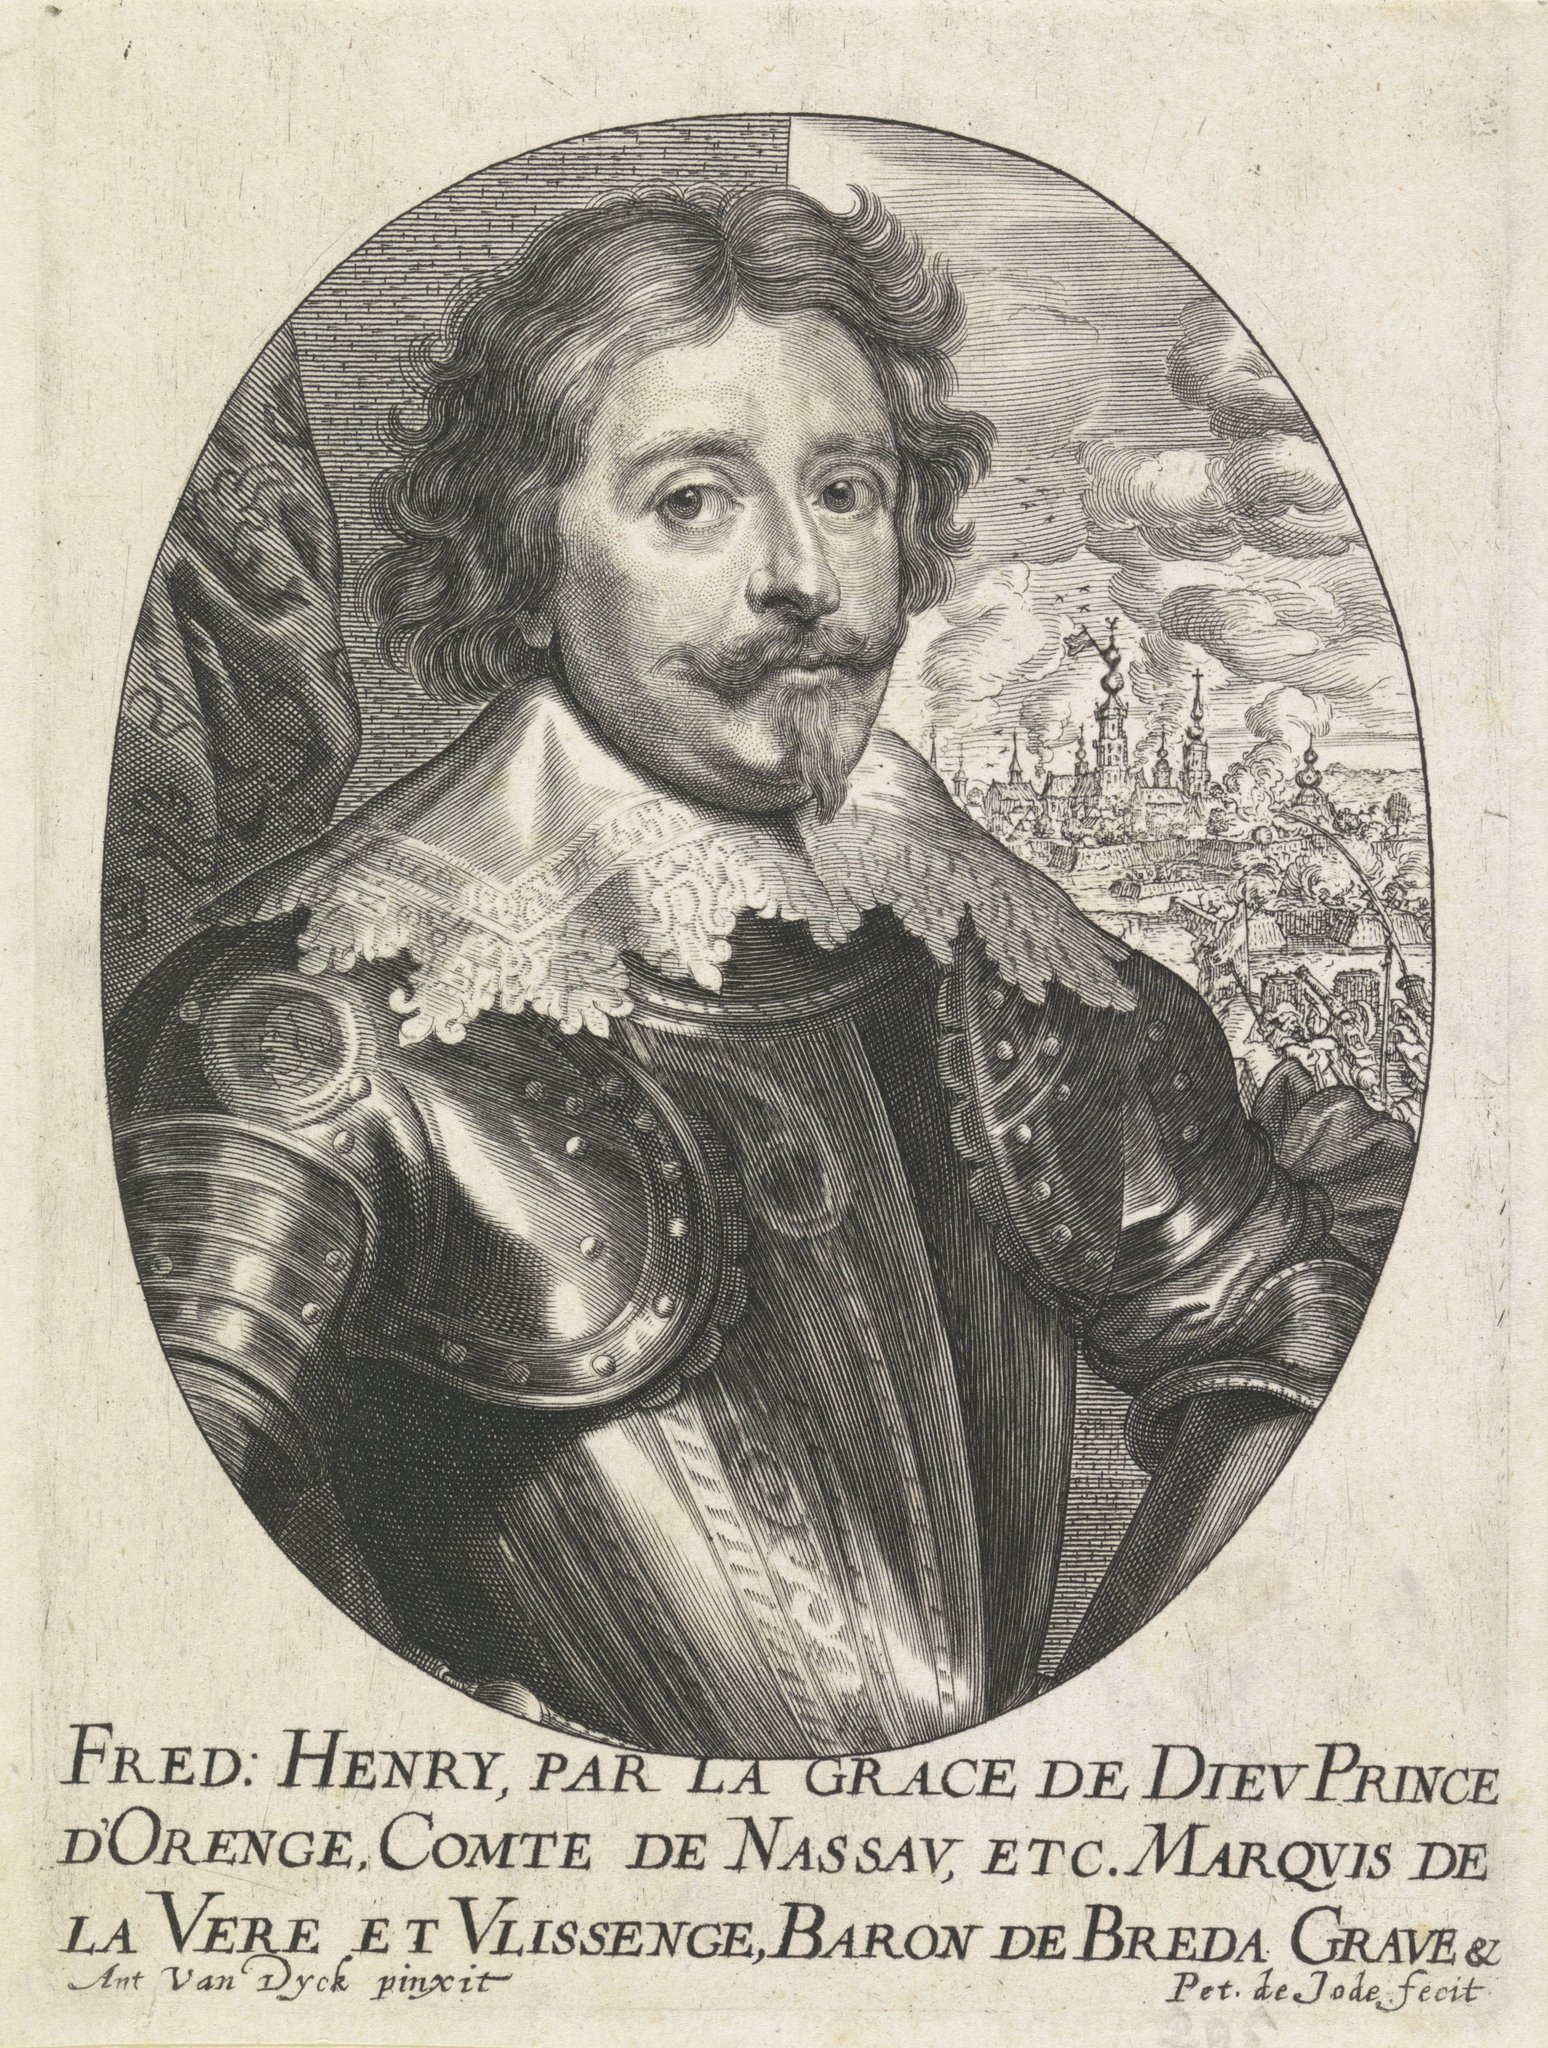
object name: print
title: Theatrum pontificum, imperatorum, regum, ducum, principum, etc.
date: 1628-1670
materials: paper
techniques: engraving, etching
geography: antwerp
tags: delft, the hague, frederick henry (prince of orange)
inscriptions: collector's mark: Lugt 240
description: De hier vermelde titel verwijst naar de hoogst verkregen titel van de geportretteerde, niet per se naar de titel die de geportretteerde op deze voorstelling draagt.